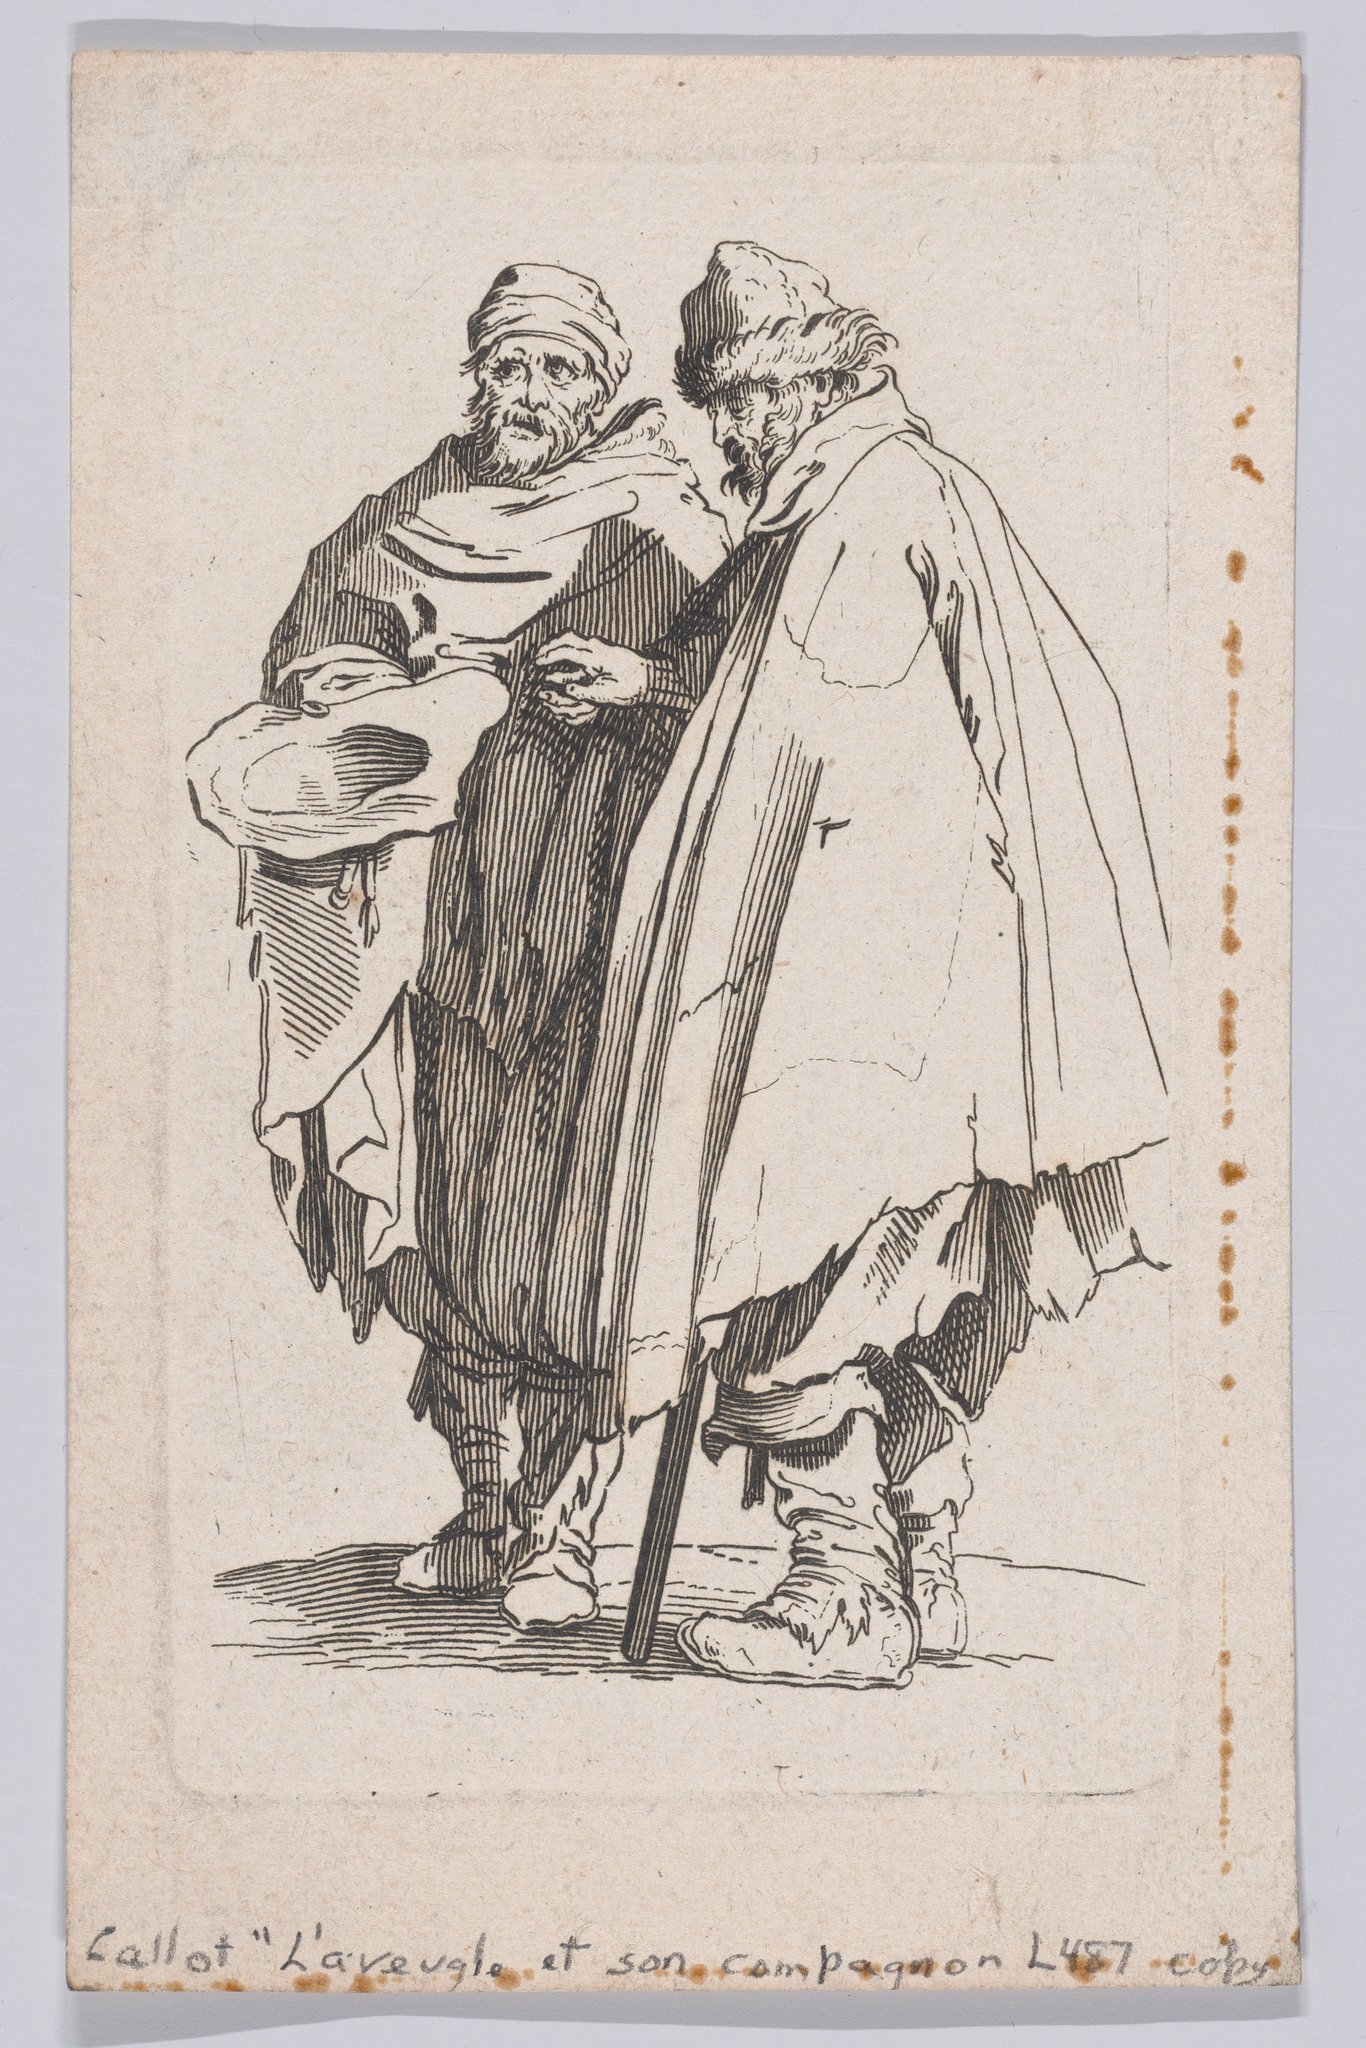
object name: print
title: Copy of L'Aveugle et son Compagnon (The Blind Man and his Companion), from "Les Gueux suite appelée aussi Les Mendiants, Les Baroni, ou Les Barons" (The Beggars, also called the Barons)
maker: Anonymous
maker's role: artist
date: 1601-1700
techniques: etching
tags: men